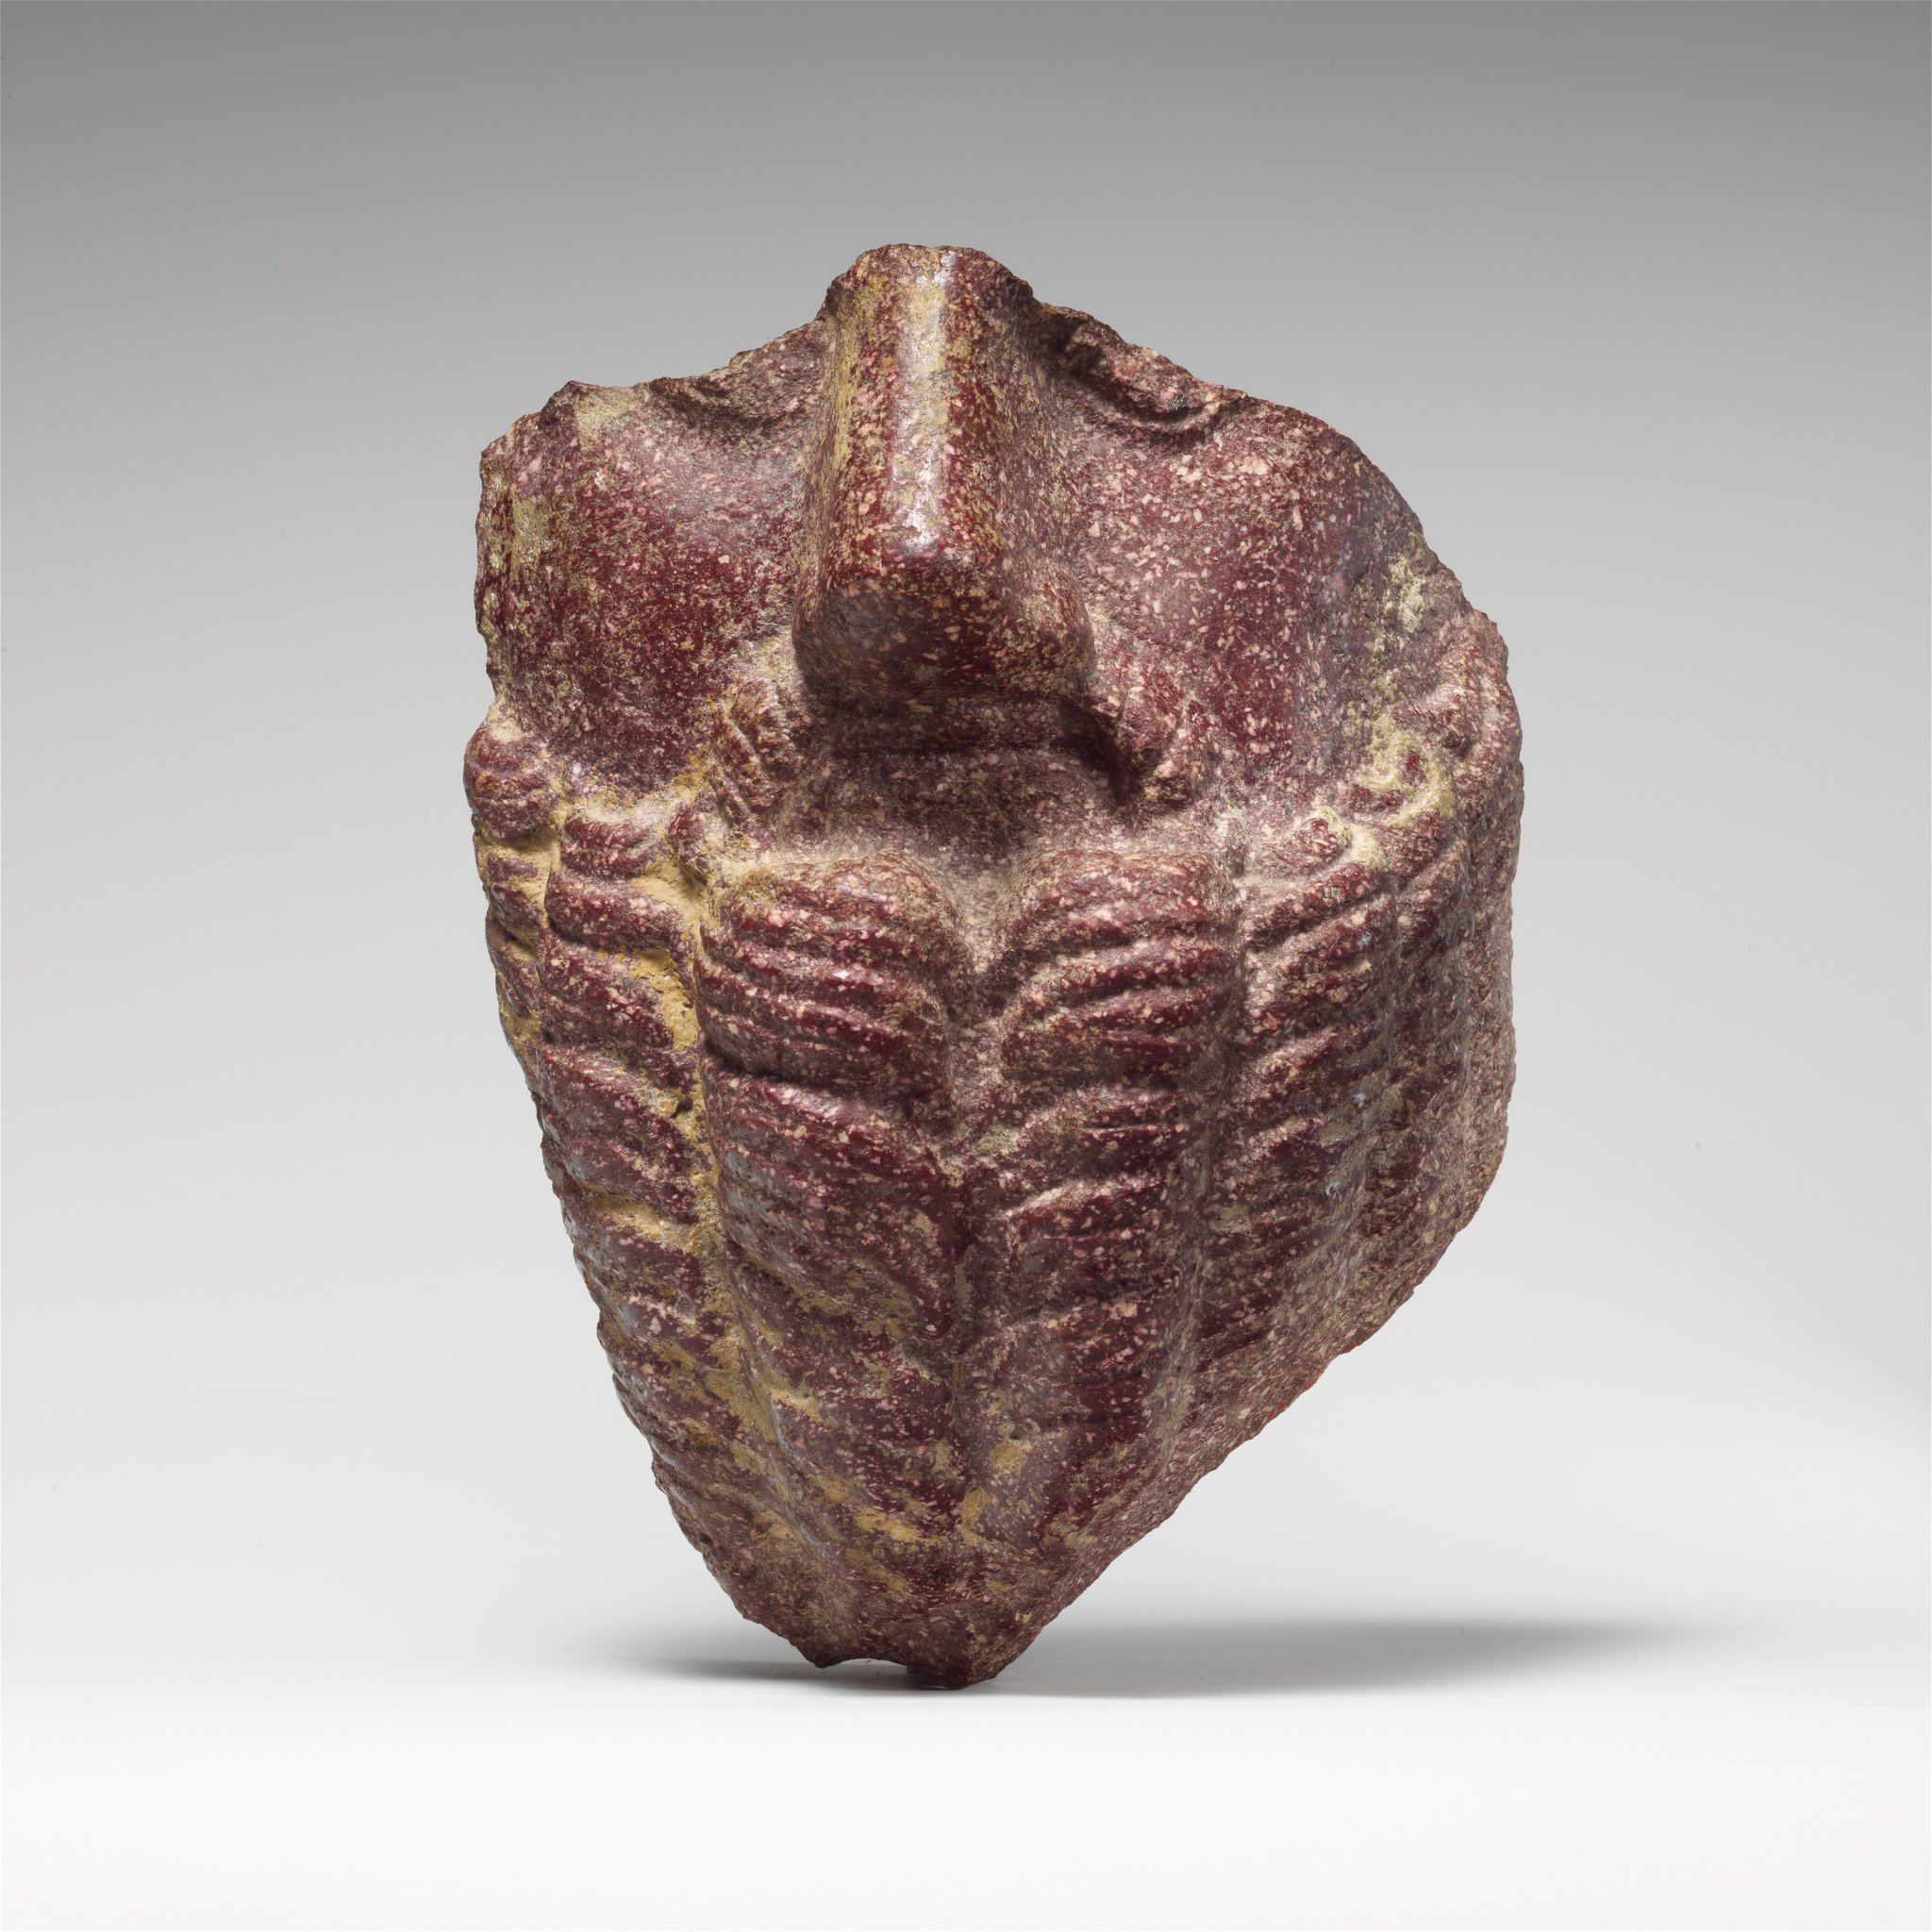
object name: head of a man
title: Fragmentary porphyry head of a bearded man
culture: roman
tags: heads,men